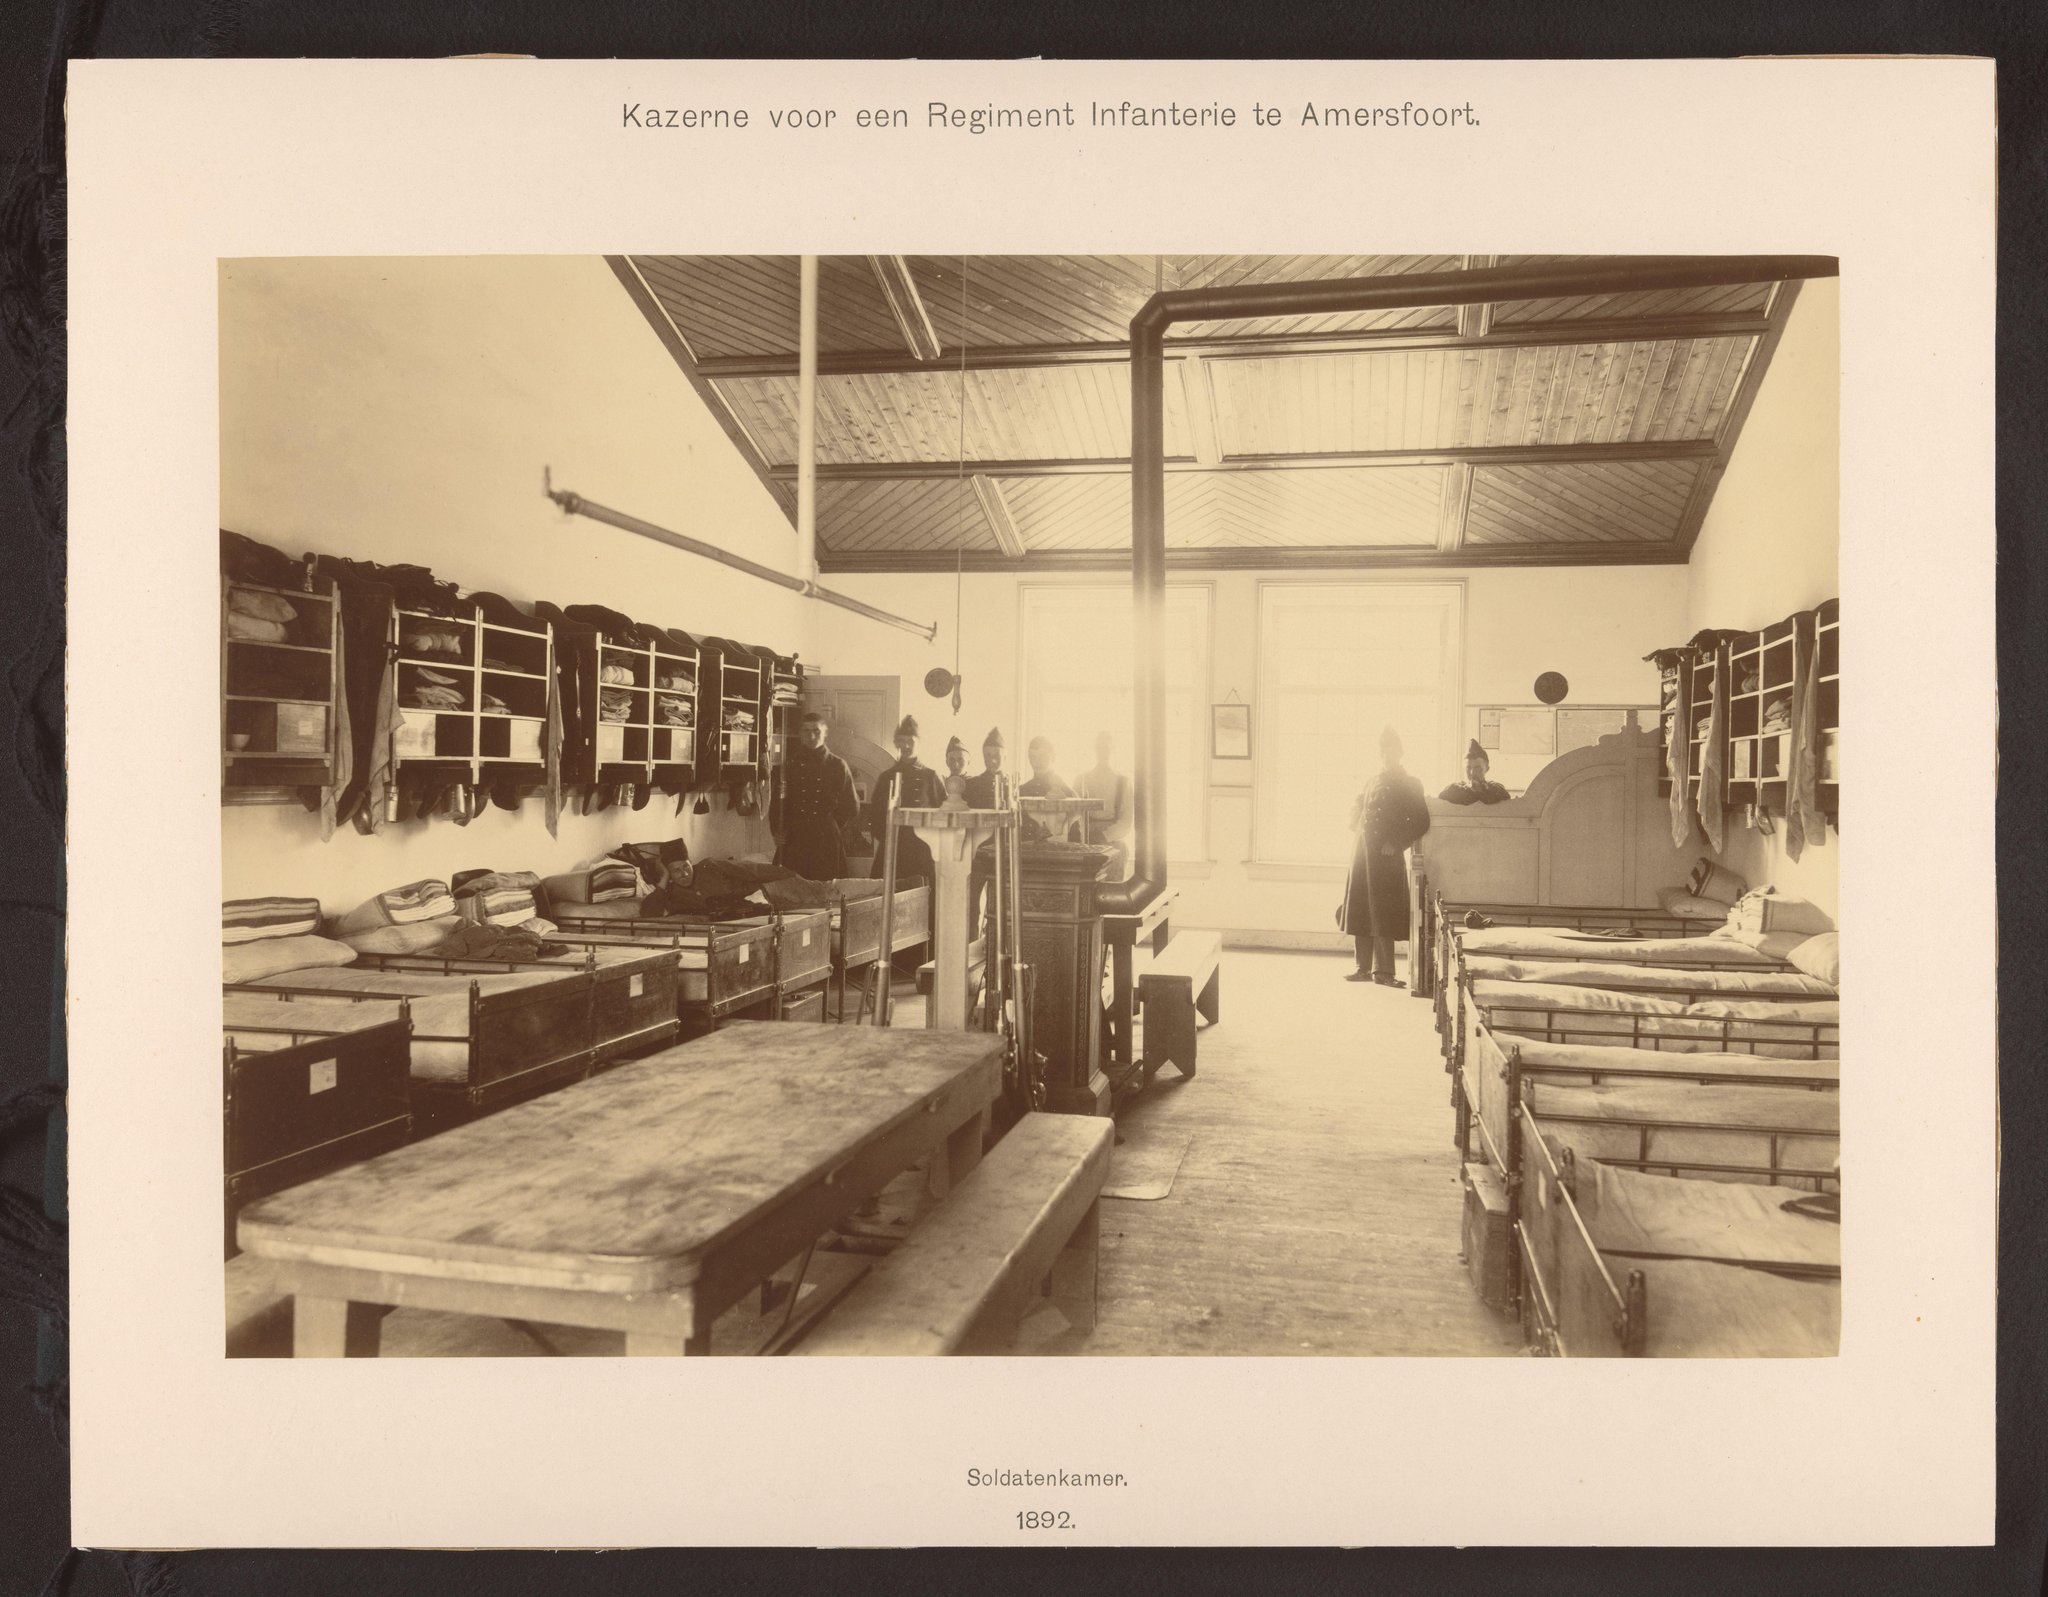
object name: photograph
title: Kazerne voor een Regiment Infanterie te Amersfoort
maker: p. oosterhuis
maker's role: fotograaf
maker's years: 1816-1885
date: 1892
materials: cardboard, paper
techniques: photography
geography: amersfoort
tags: netherlands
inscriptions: date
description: Foto, geelbruin, op karton, met boven titel en onder omschrijving.